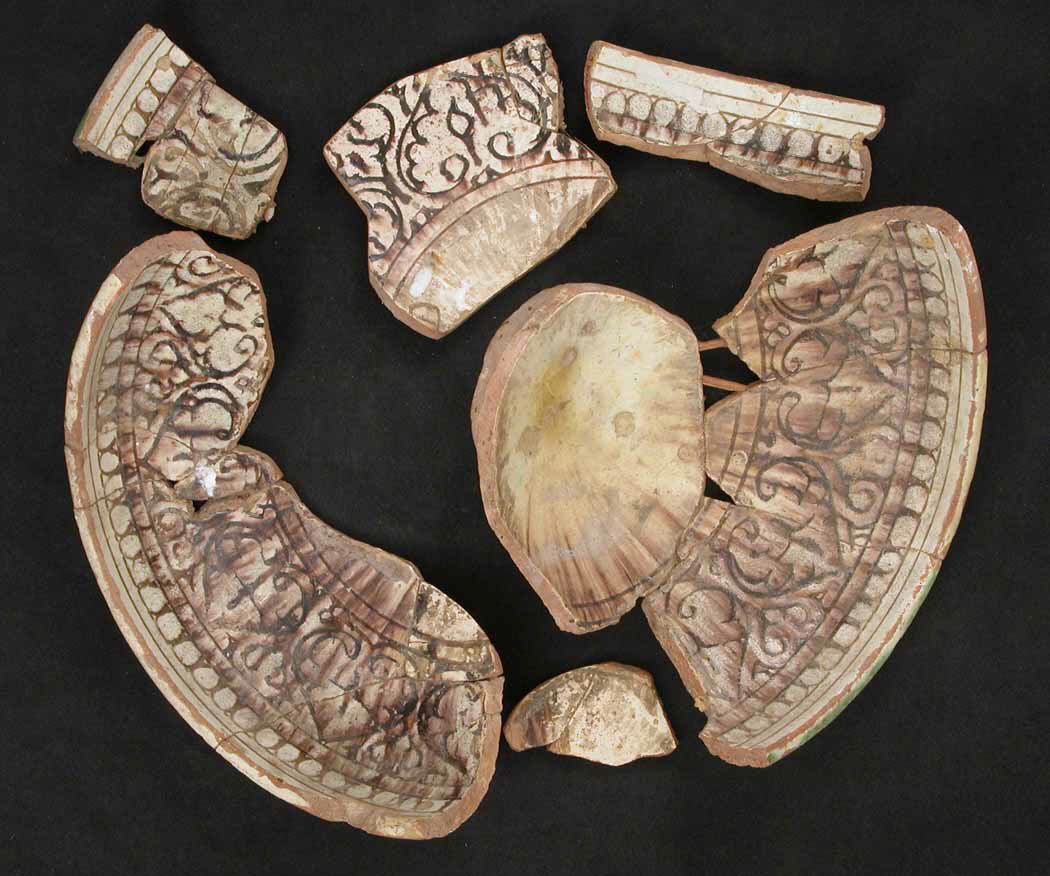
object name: fragmentary bowl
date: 901-1200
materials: earthenware, engobe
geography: iran